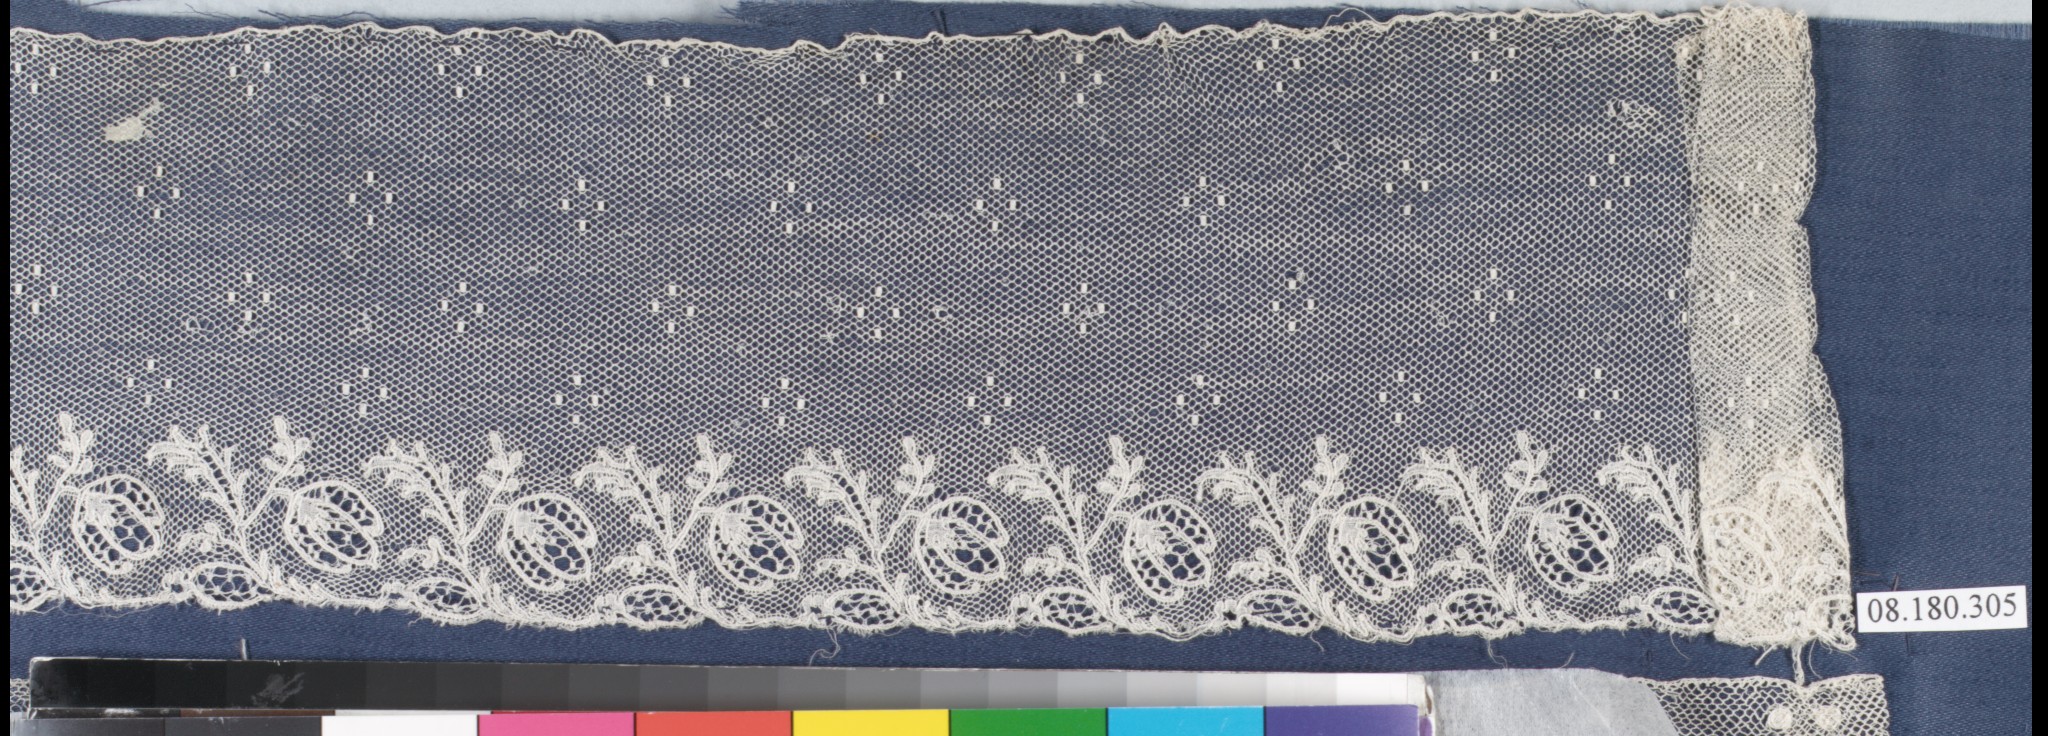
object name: piece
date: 1801-1900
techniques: lace